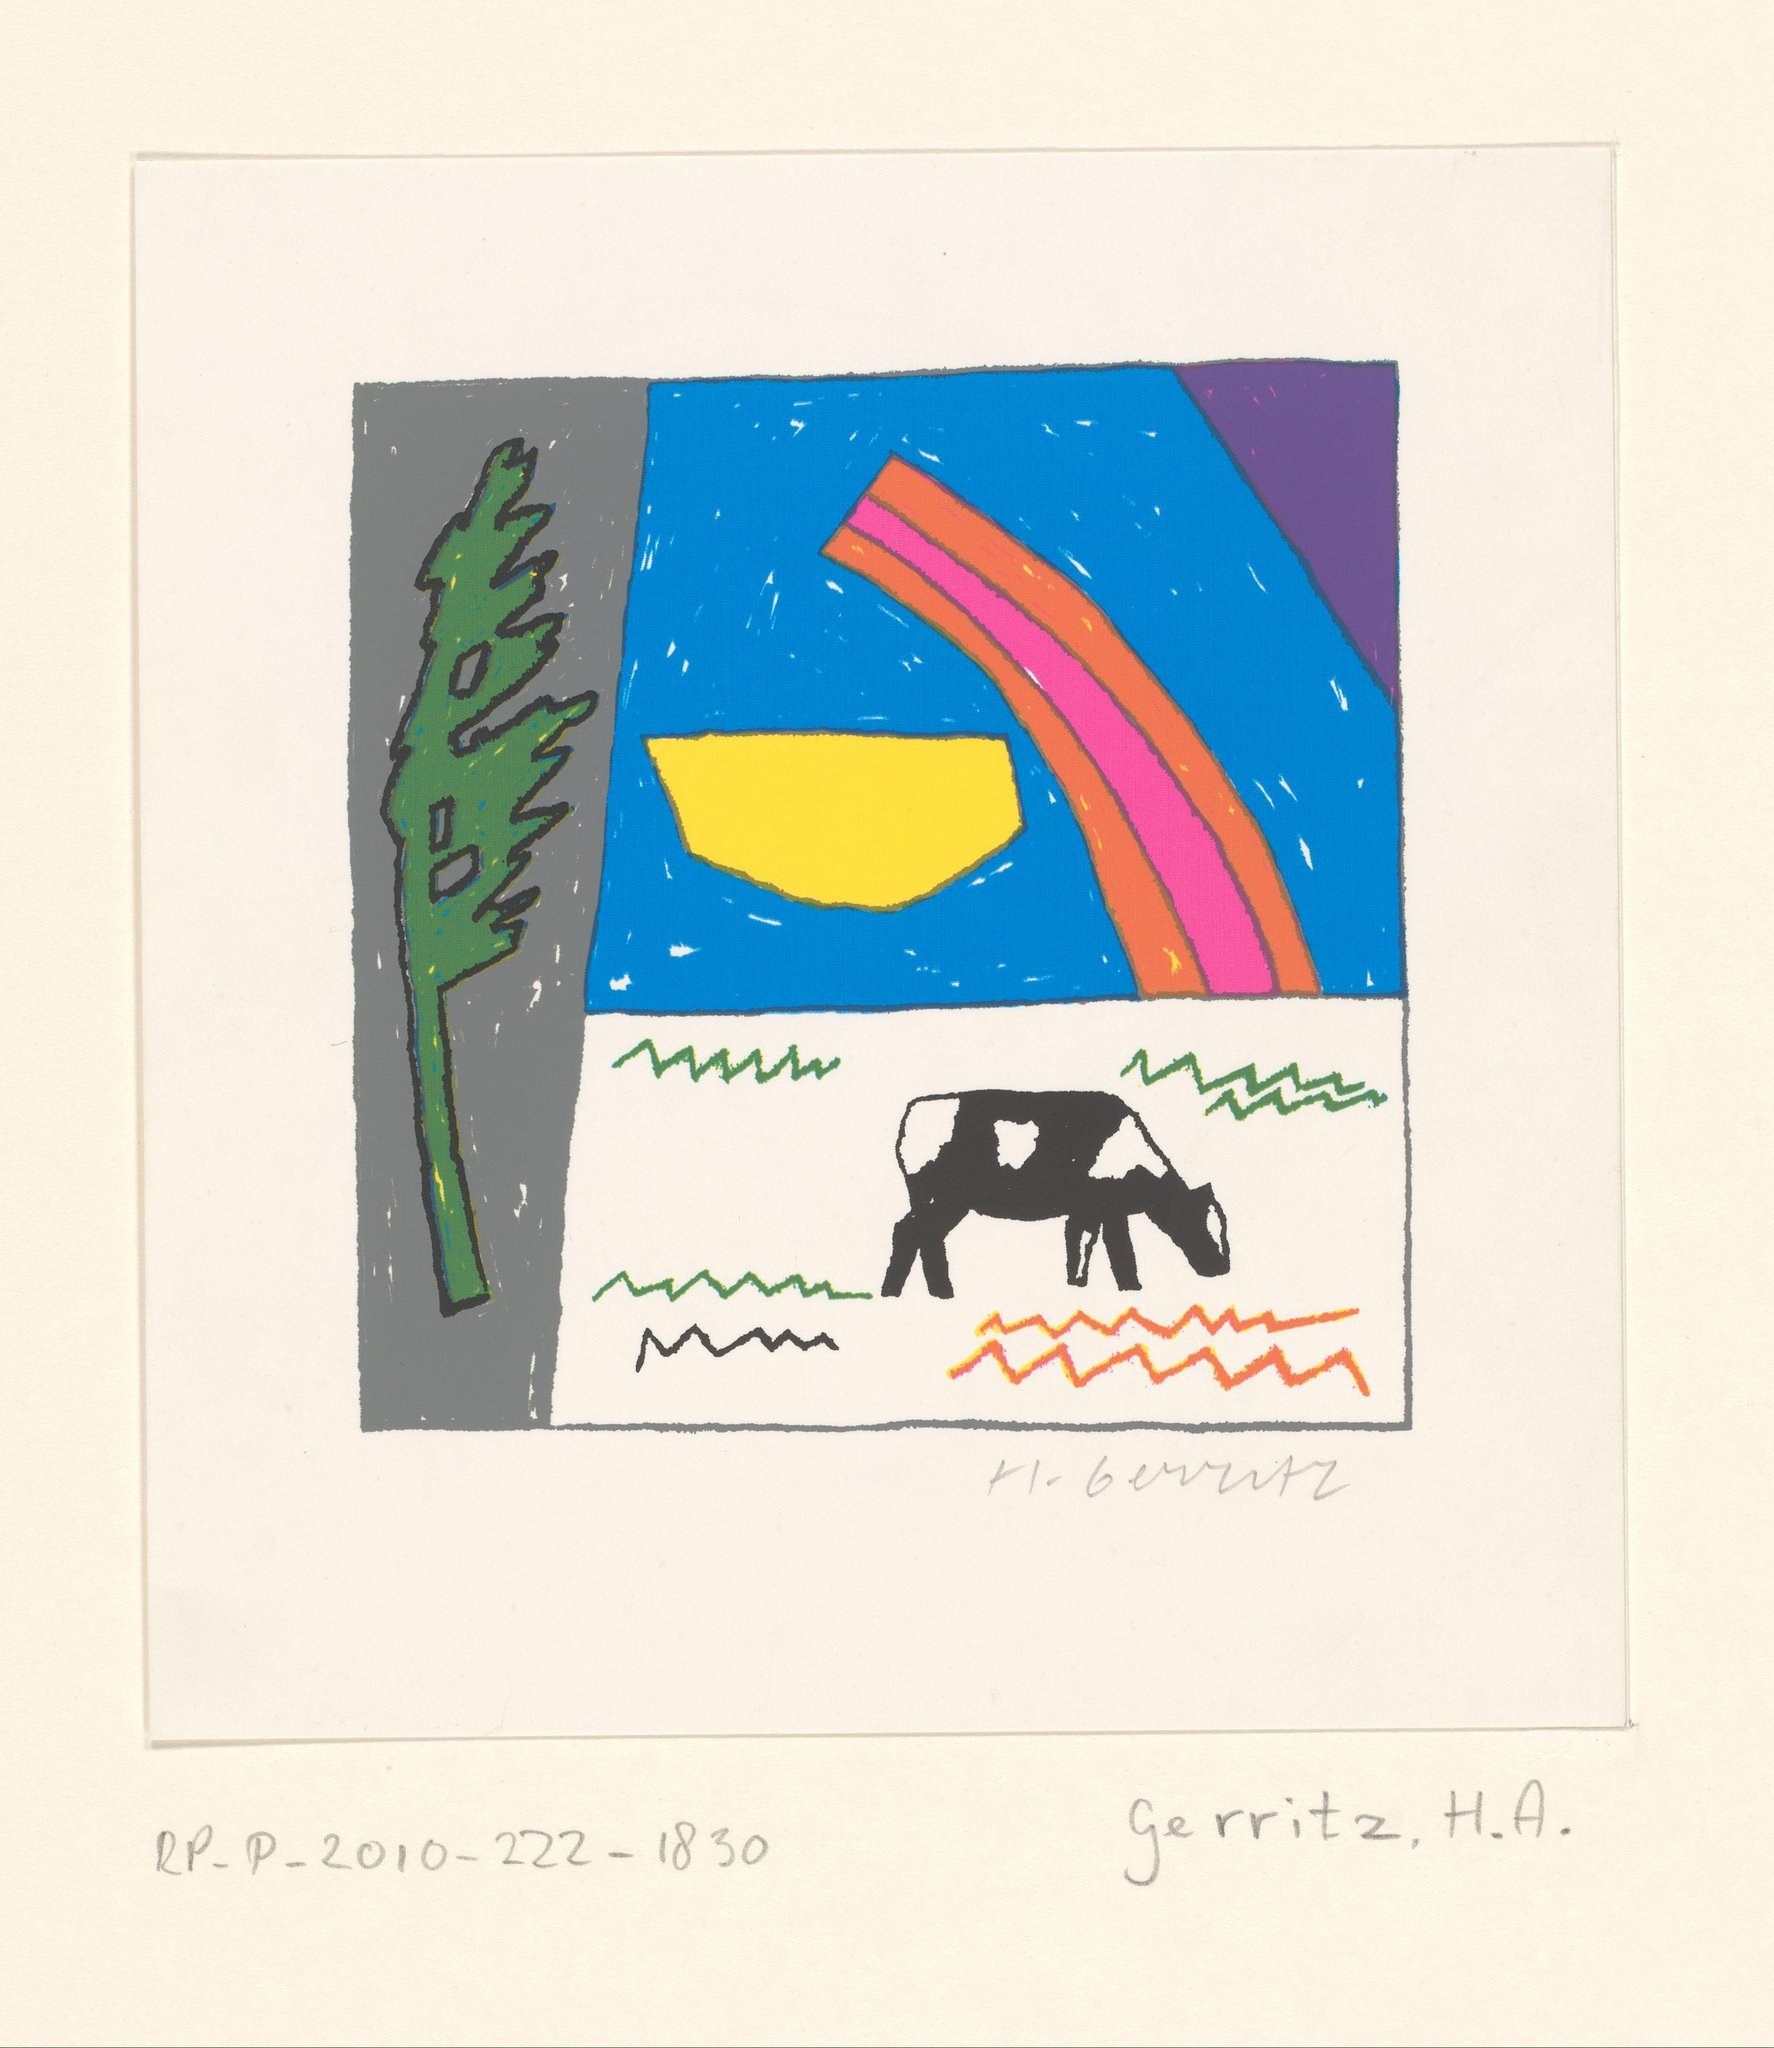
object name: print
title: Koe, vogel, schildersezel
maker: harrie a. gerritz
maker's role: draughtsman, painter, print maker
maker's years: 1940-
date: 1985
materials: paper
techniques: lithograph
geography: amsterdam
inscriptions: signature and date: ‘H. Gerritz’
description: De huidige titel en serietitel zijn door het museum toegekend bij gebrek aan informatie over de originele titels.